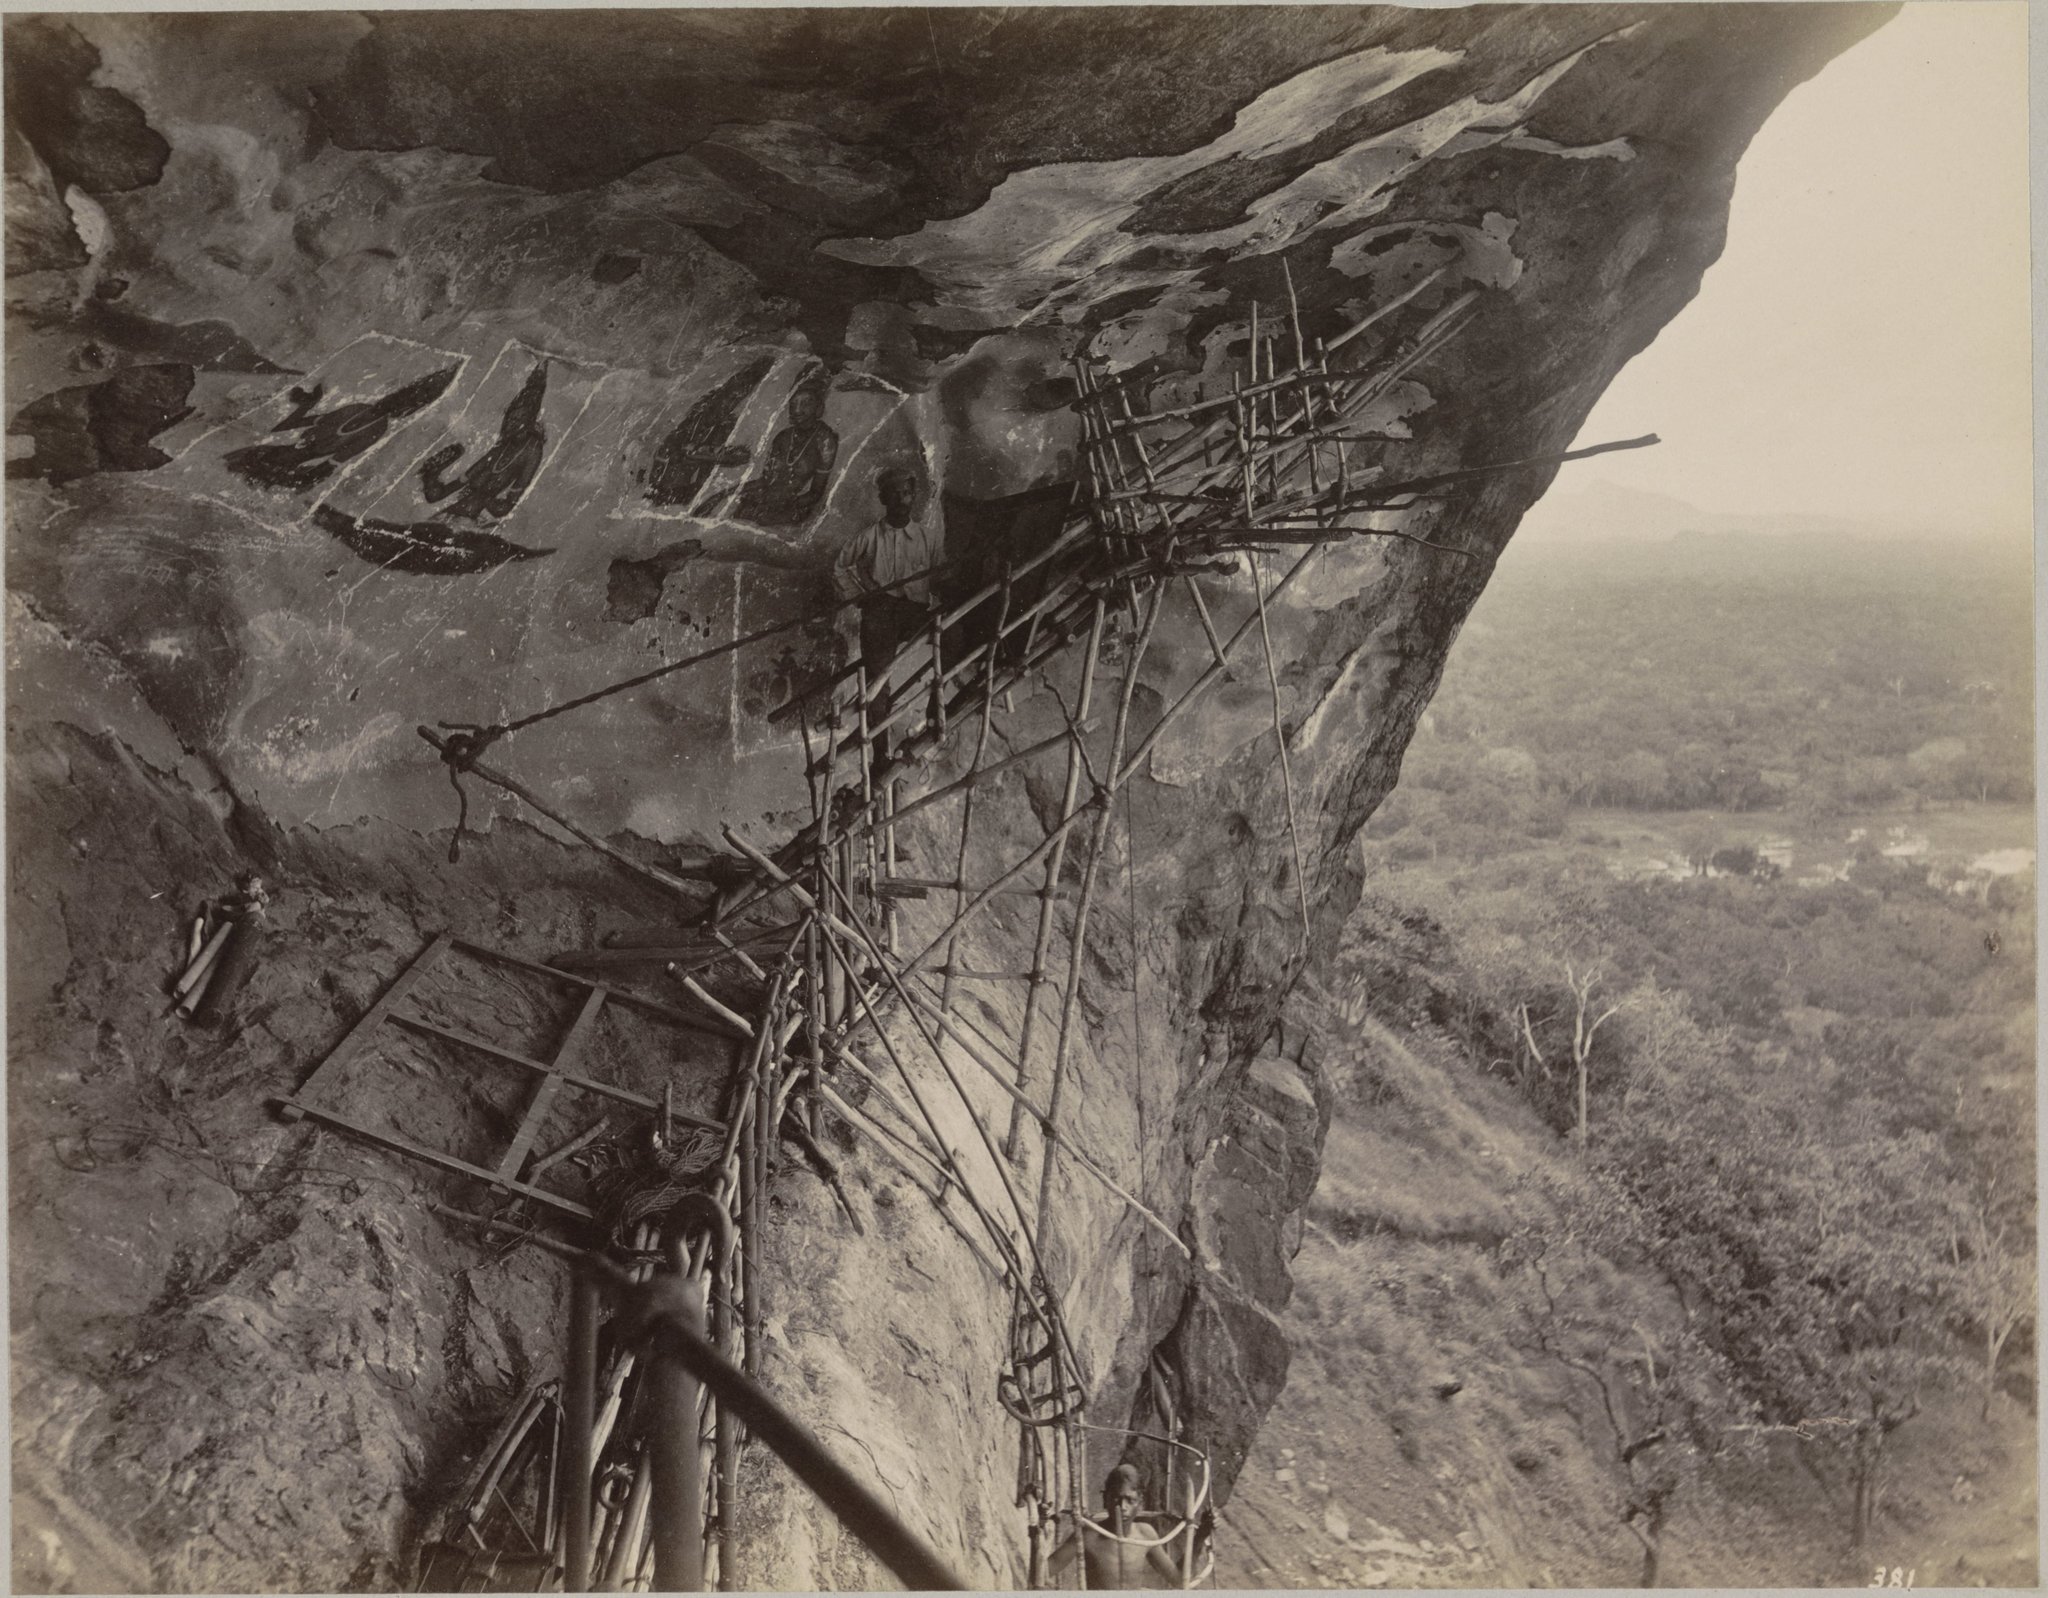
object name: photograph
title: Frescoes on the rock, Sigiriya, Sri Lanka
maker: Anonymous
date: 1895-1915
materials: cardboard, paper, photographic support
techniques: albumen print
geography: sigiriya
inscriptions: inscription: ‘7. Sigiri’, number: ‘381’